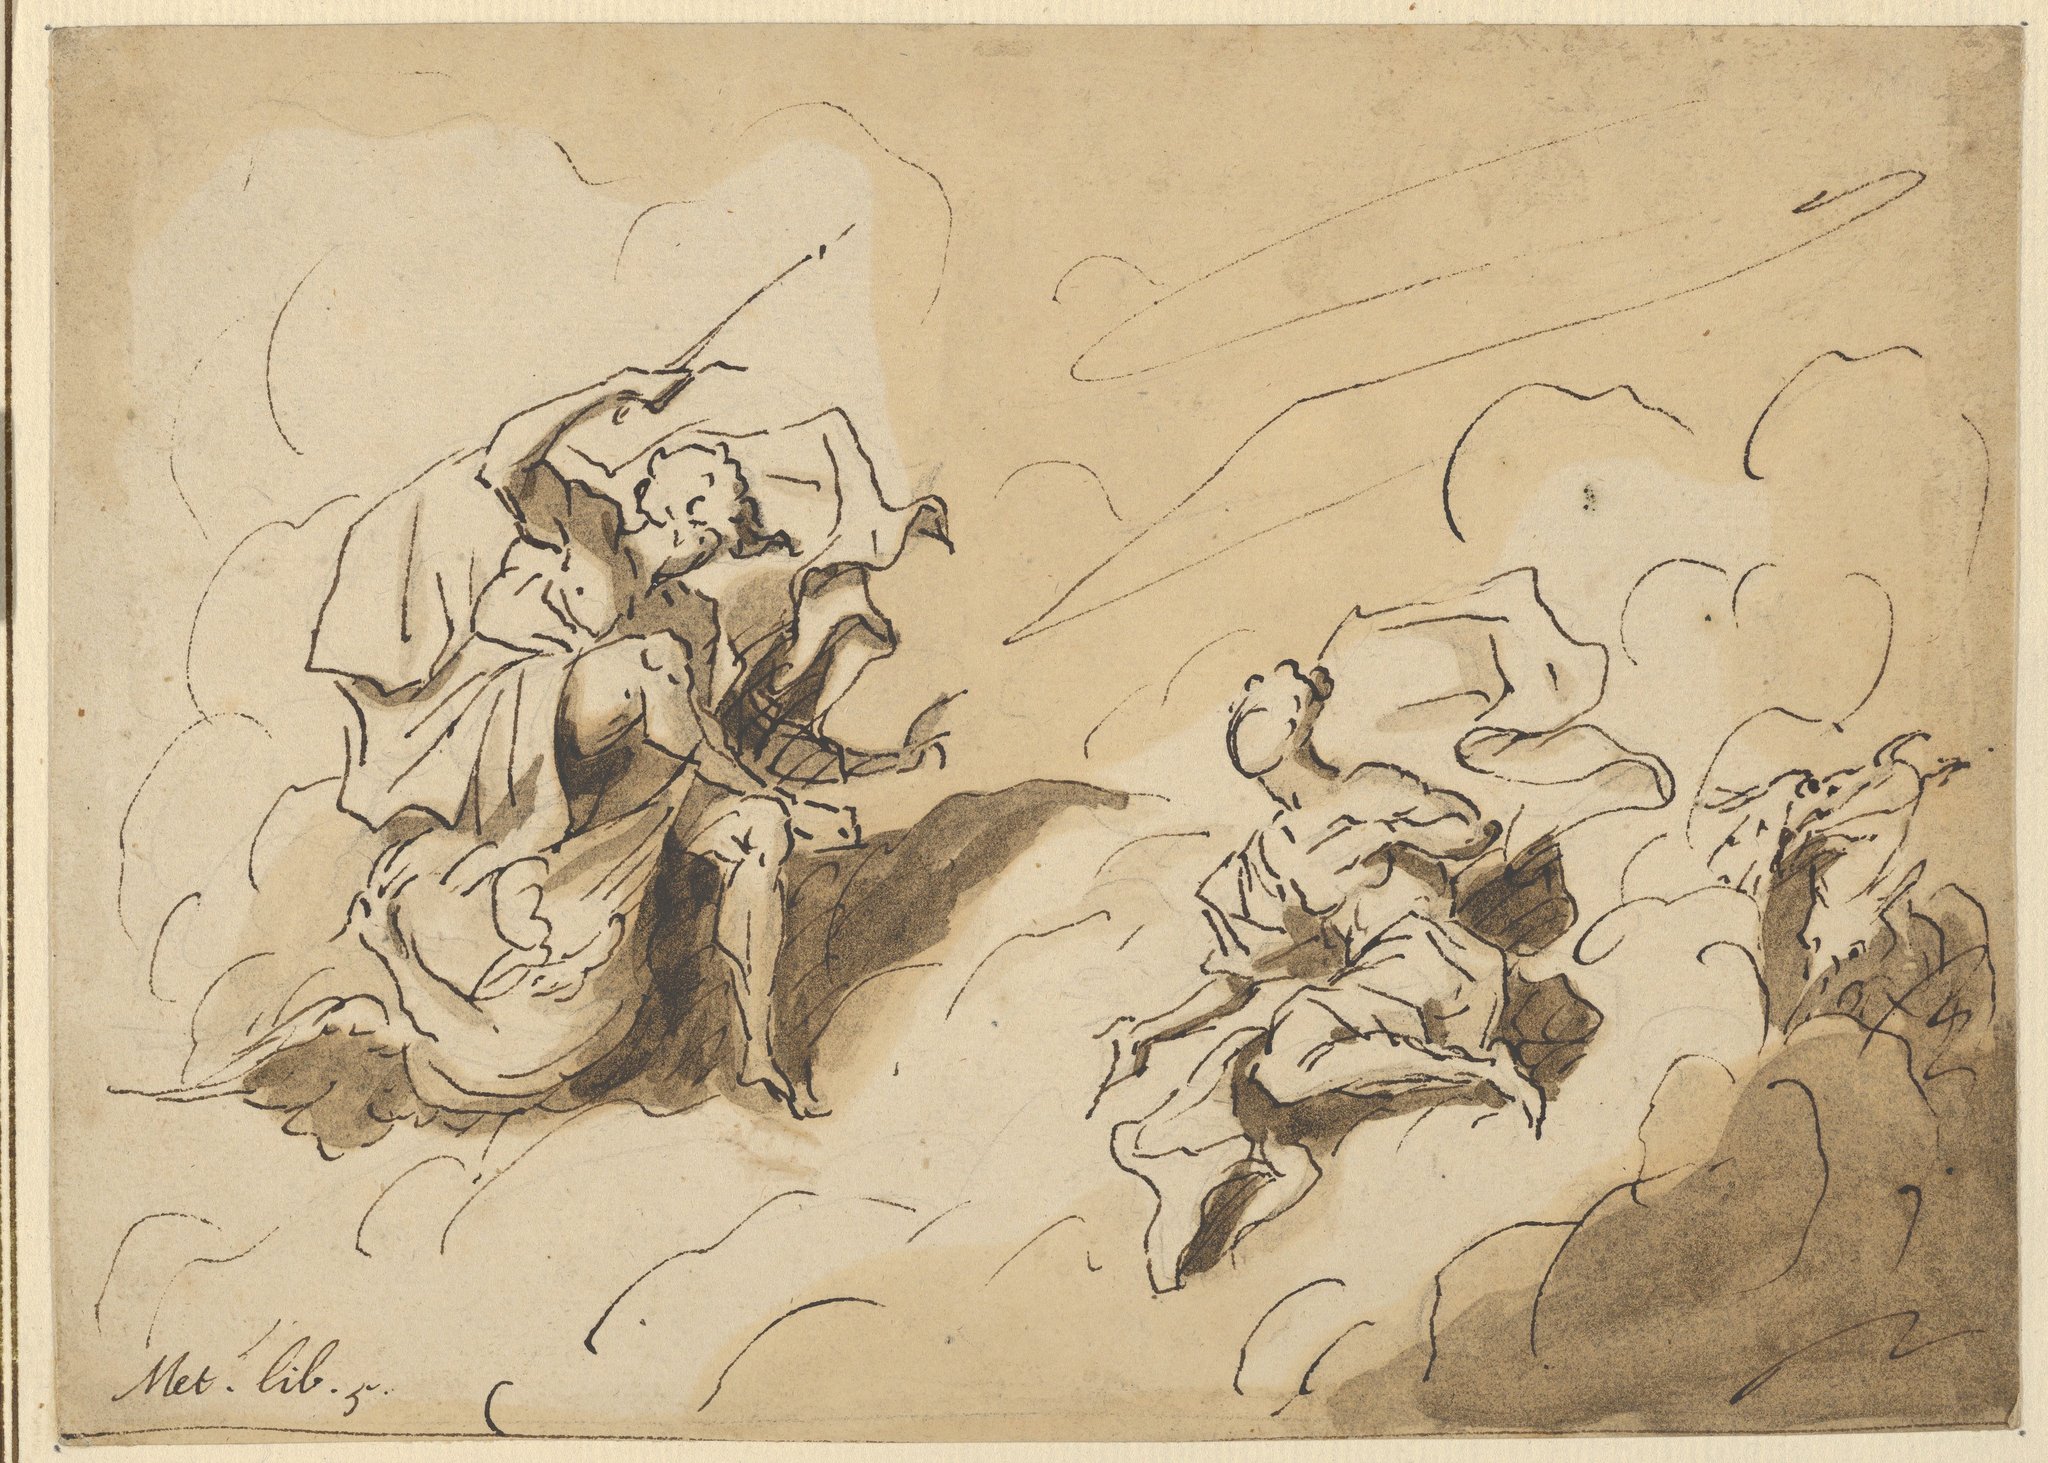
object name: drawing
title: Ceres pleading with Jove for the return of Prosperpina, from Ovid, "Metamorphoses," Book V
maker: thomas carwitham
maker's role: artist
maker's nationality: british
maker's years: 1670-1770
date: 1713-1733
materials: ink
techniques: brush, pen, wash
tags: ceres